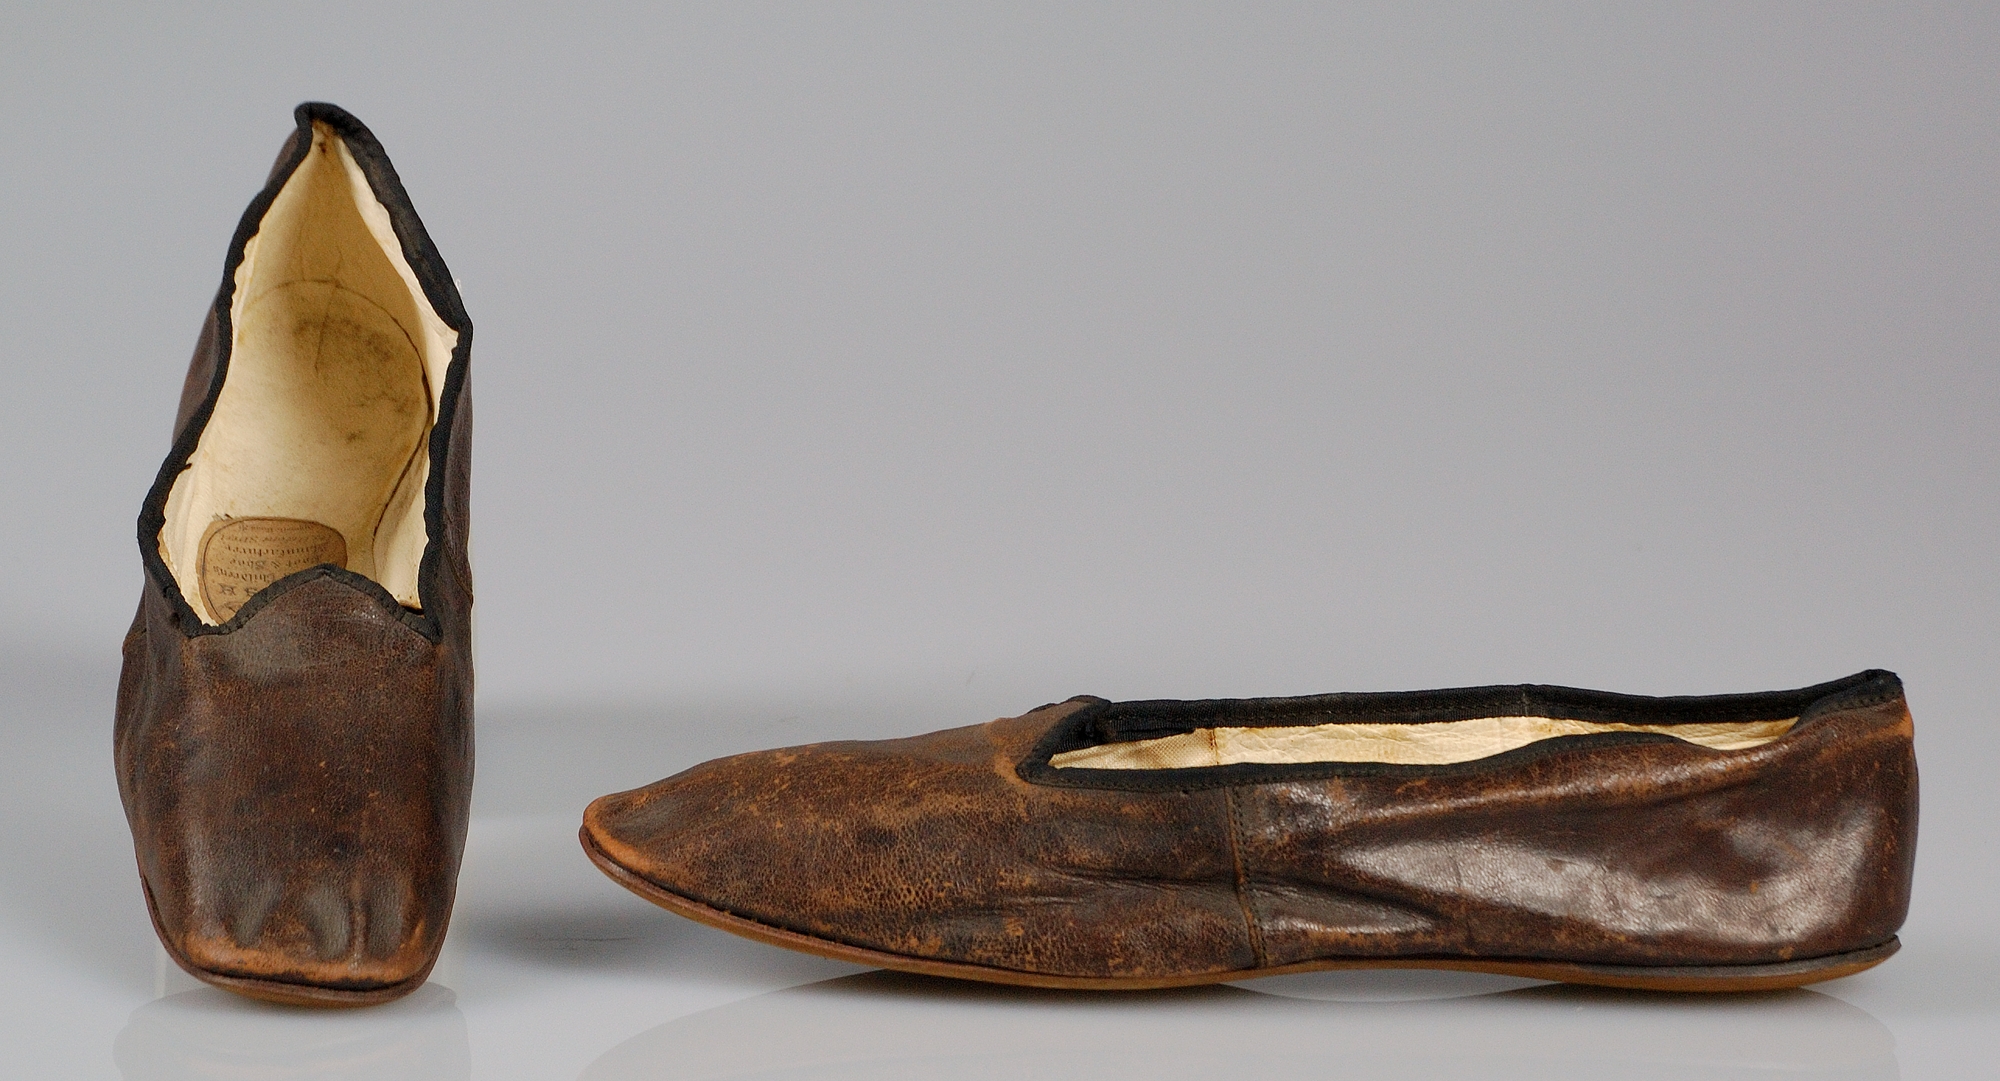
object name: slipper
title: Slippers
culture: british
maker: marsh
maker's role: maker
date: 1845-1865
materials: leather